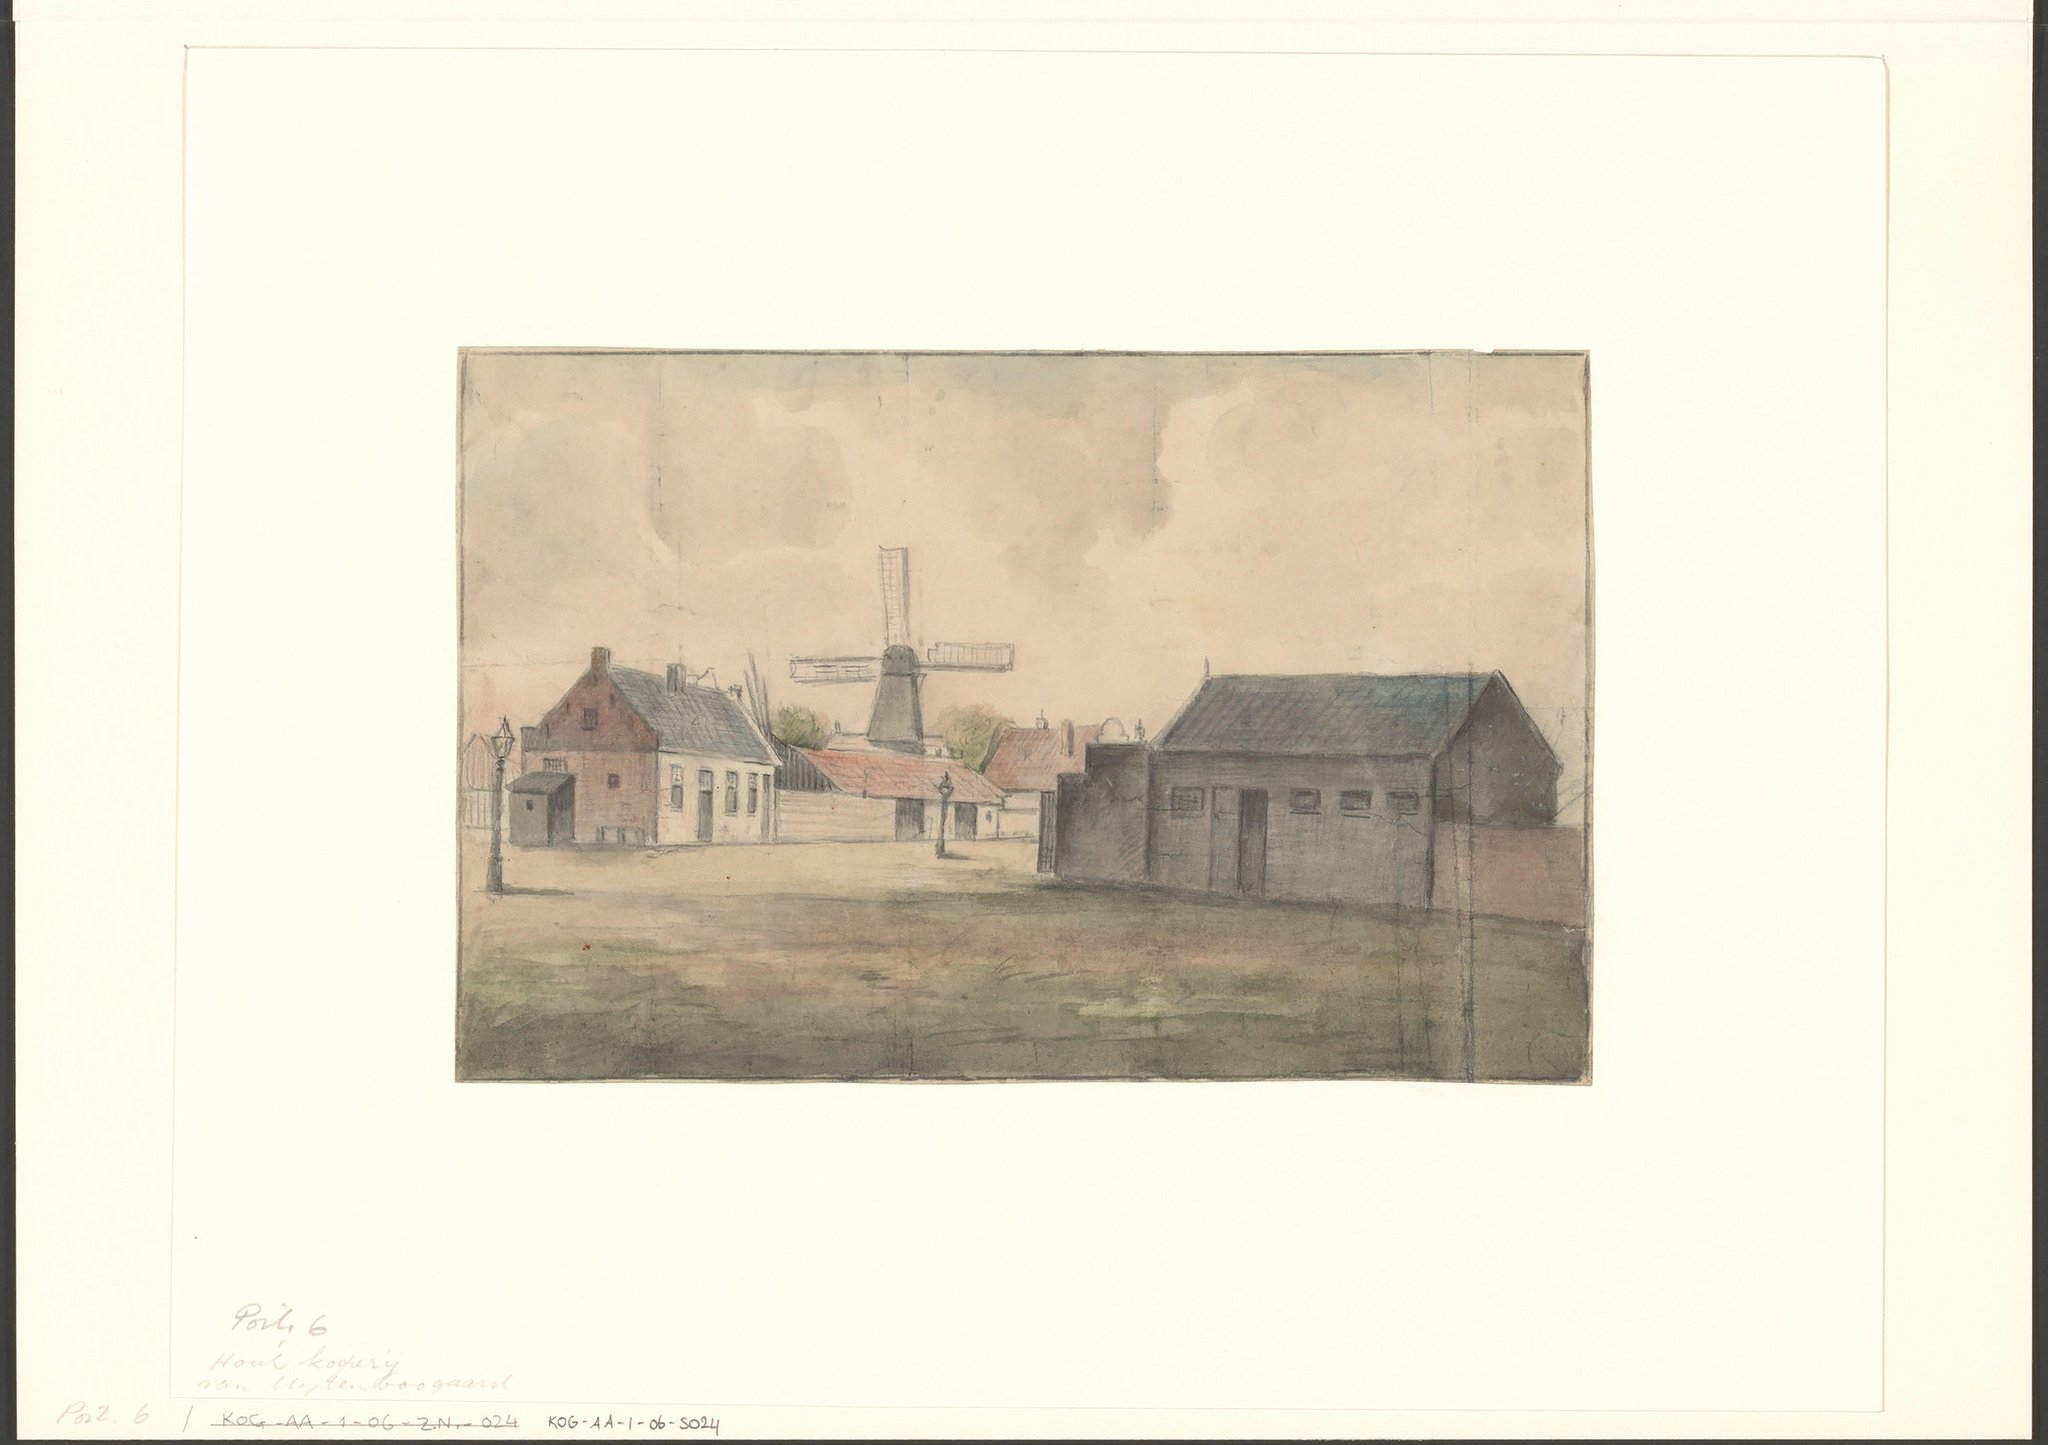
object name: drawing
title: Gezicht op een molen bij houtkoperij van Uytenboogaard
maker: albert martin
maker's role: draughtsman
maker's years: 1827-1900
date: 1837-1900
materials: ink, paper, pencil, watercolor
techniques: brush, pen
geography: amsterdam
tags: industries ~ wood, factory-building, city-view in general; 'veduta', windmill in landscape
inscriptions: inscription: ‘Hout koperij / van Uytenboogaard’, inscription: ‘Port. 6’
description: Onderwerpsrubriek binnen de Atlas Amsterdam: Buitensingel of wel: Gezichten langs en op de Stadsvest van Haarlemmerpoort tot Raampoort.